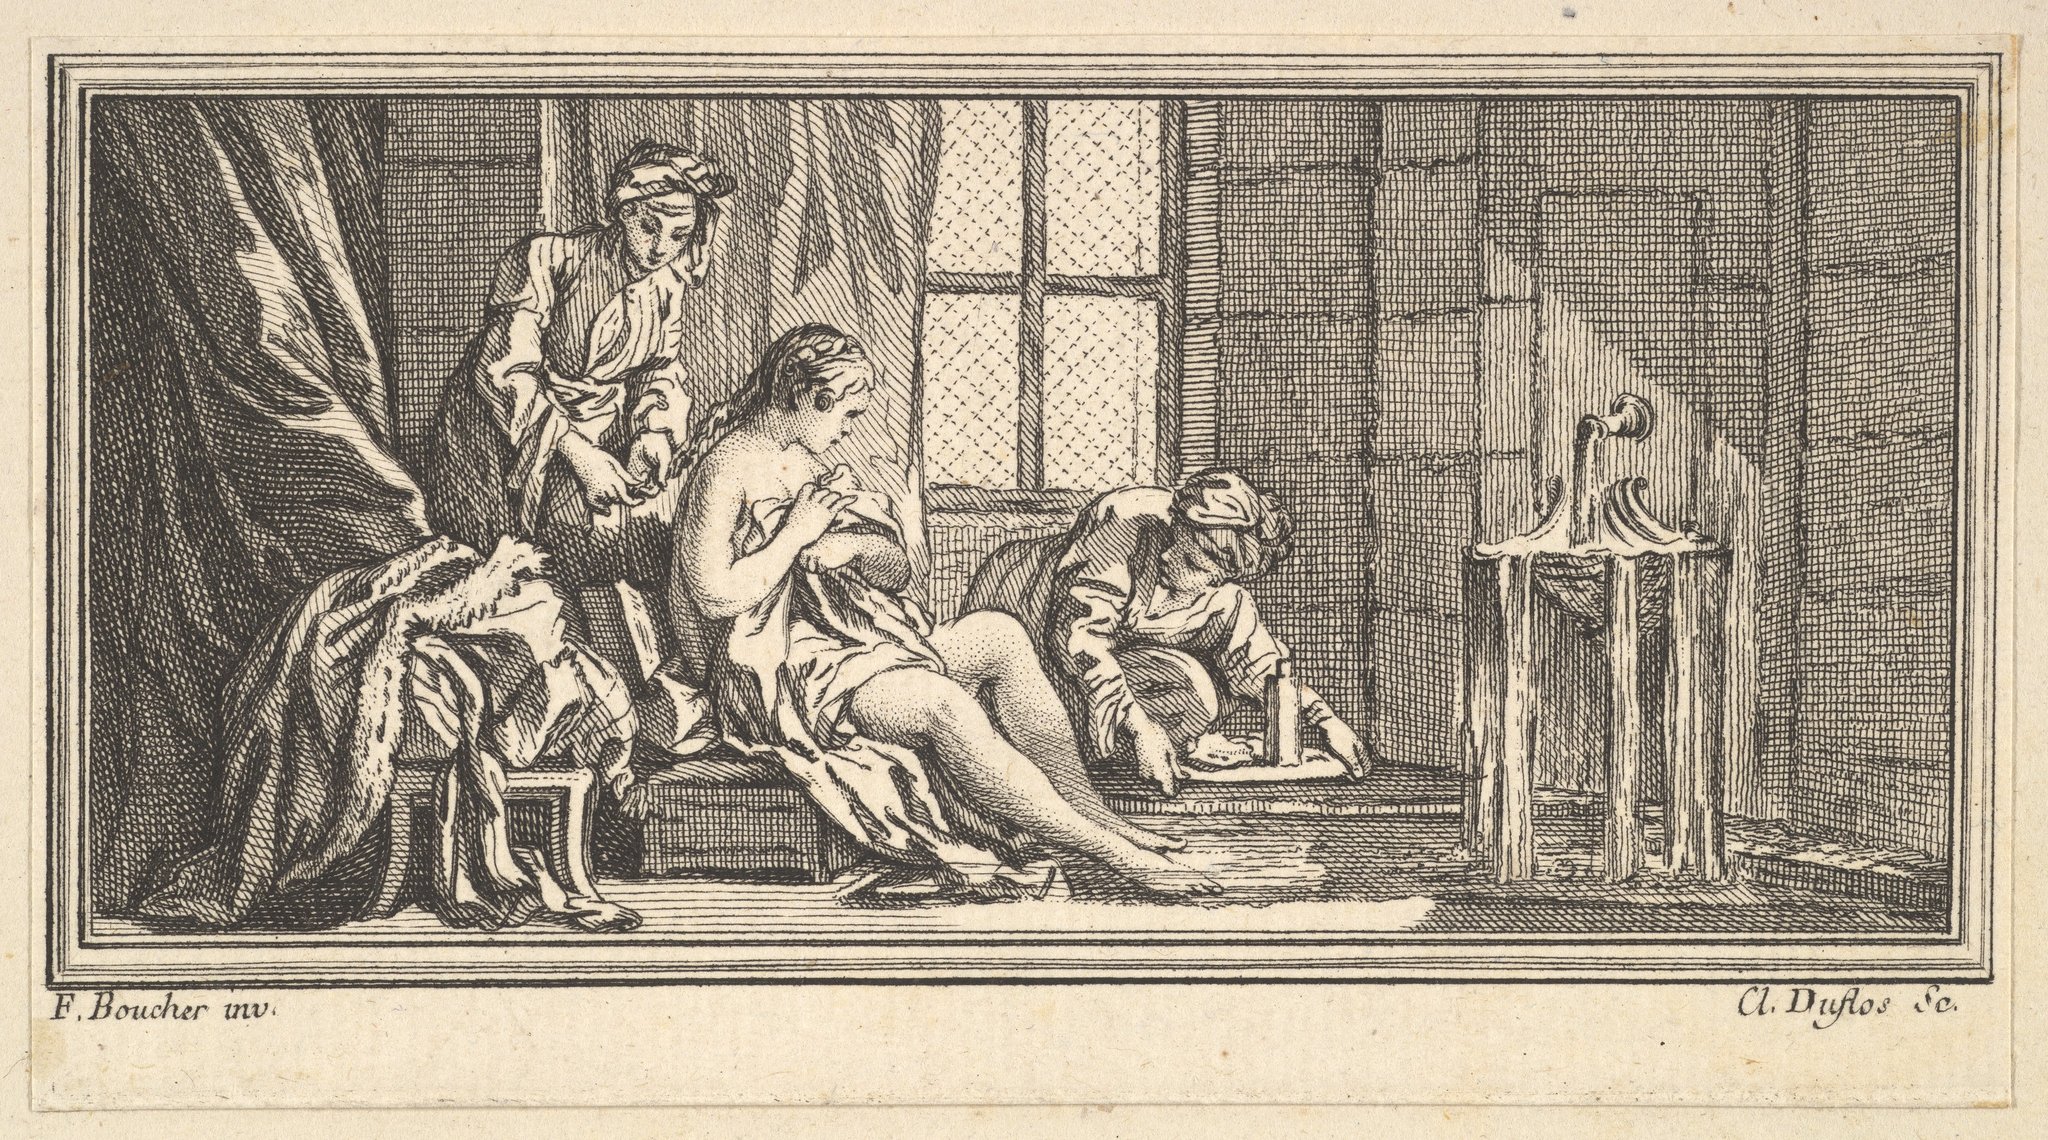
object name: print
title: Sultana at Her Toilet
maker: claude augustin duflos le jeune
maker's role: artist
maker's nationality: french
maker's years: 1700-1786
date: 1746-1747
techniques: engraving, etching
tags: bathrooms,women